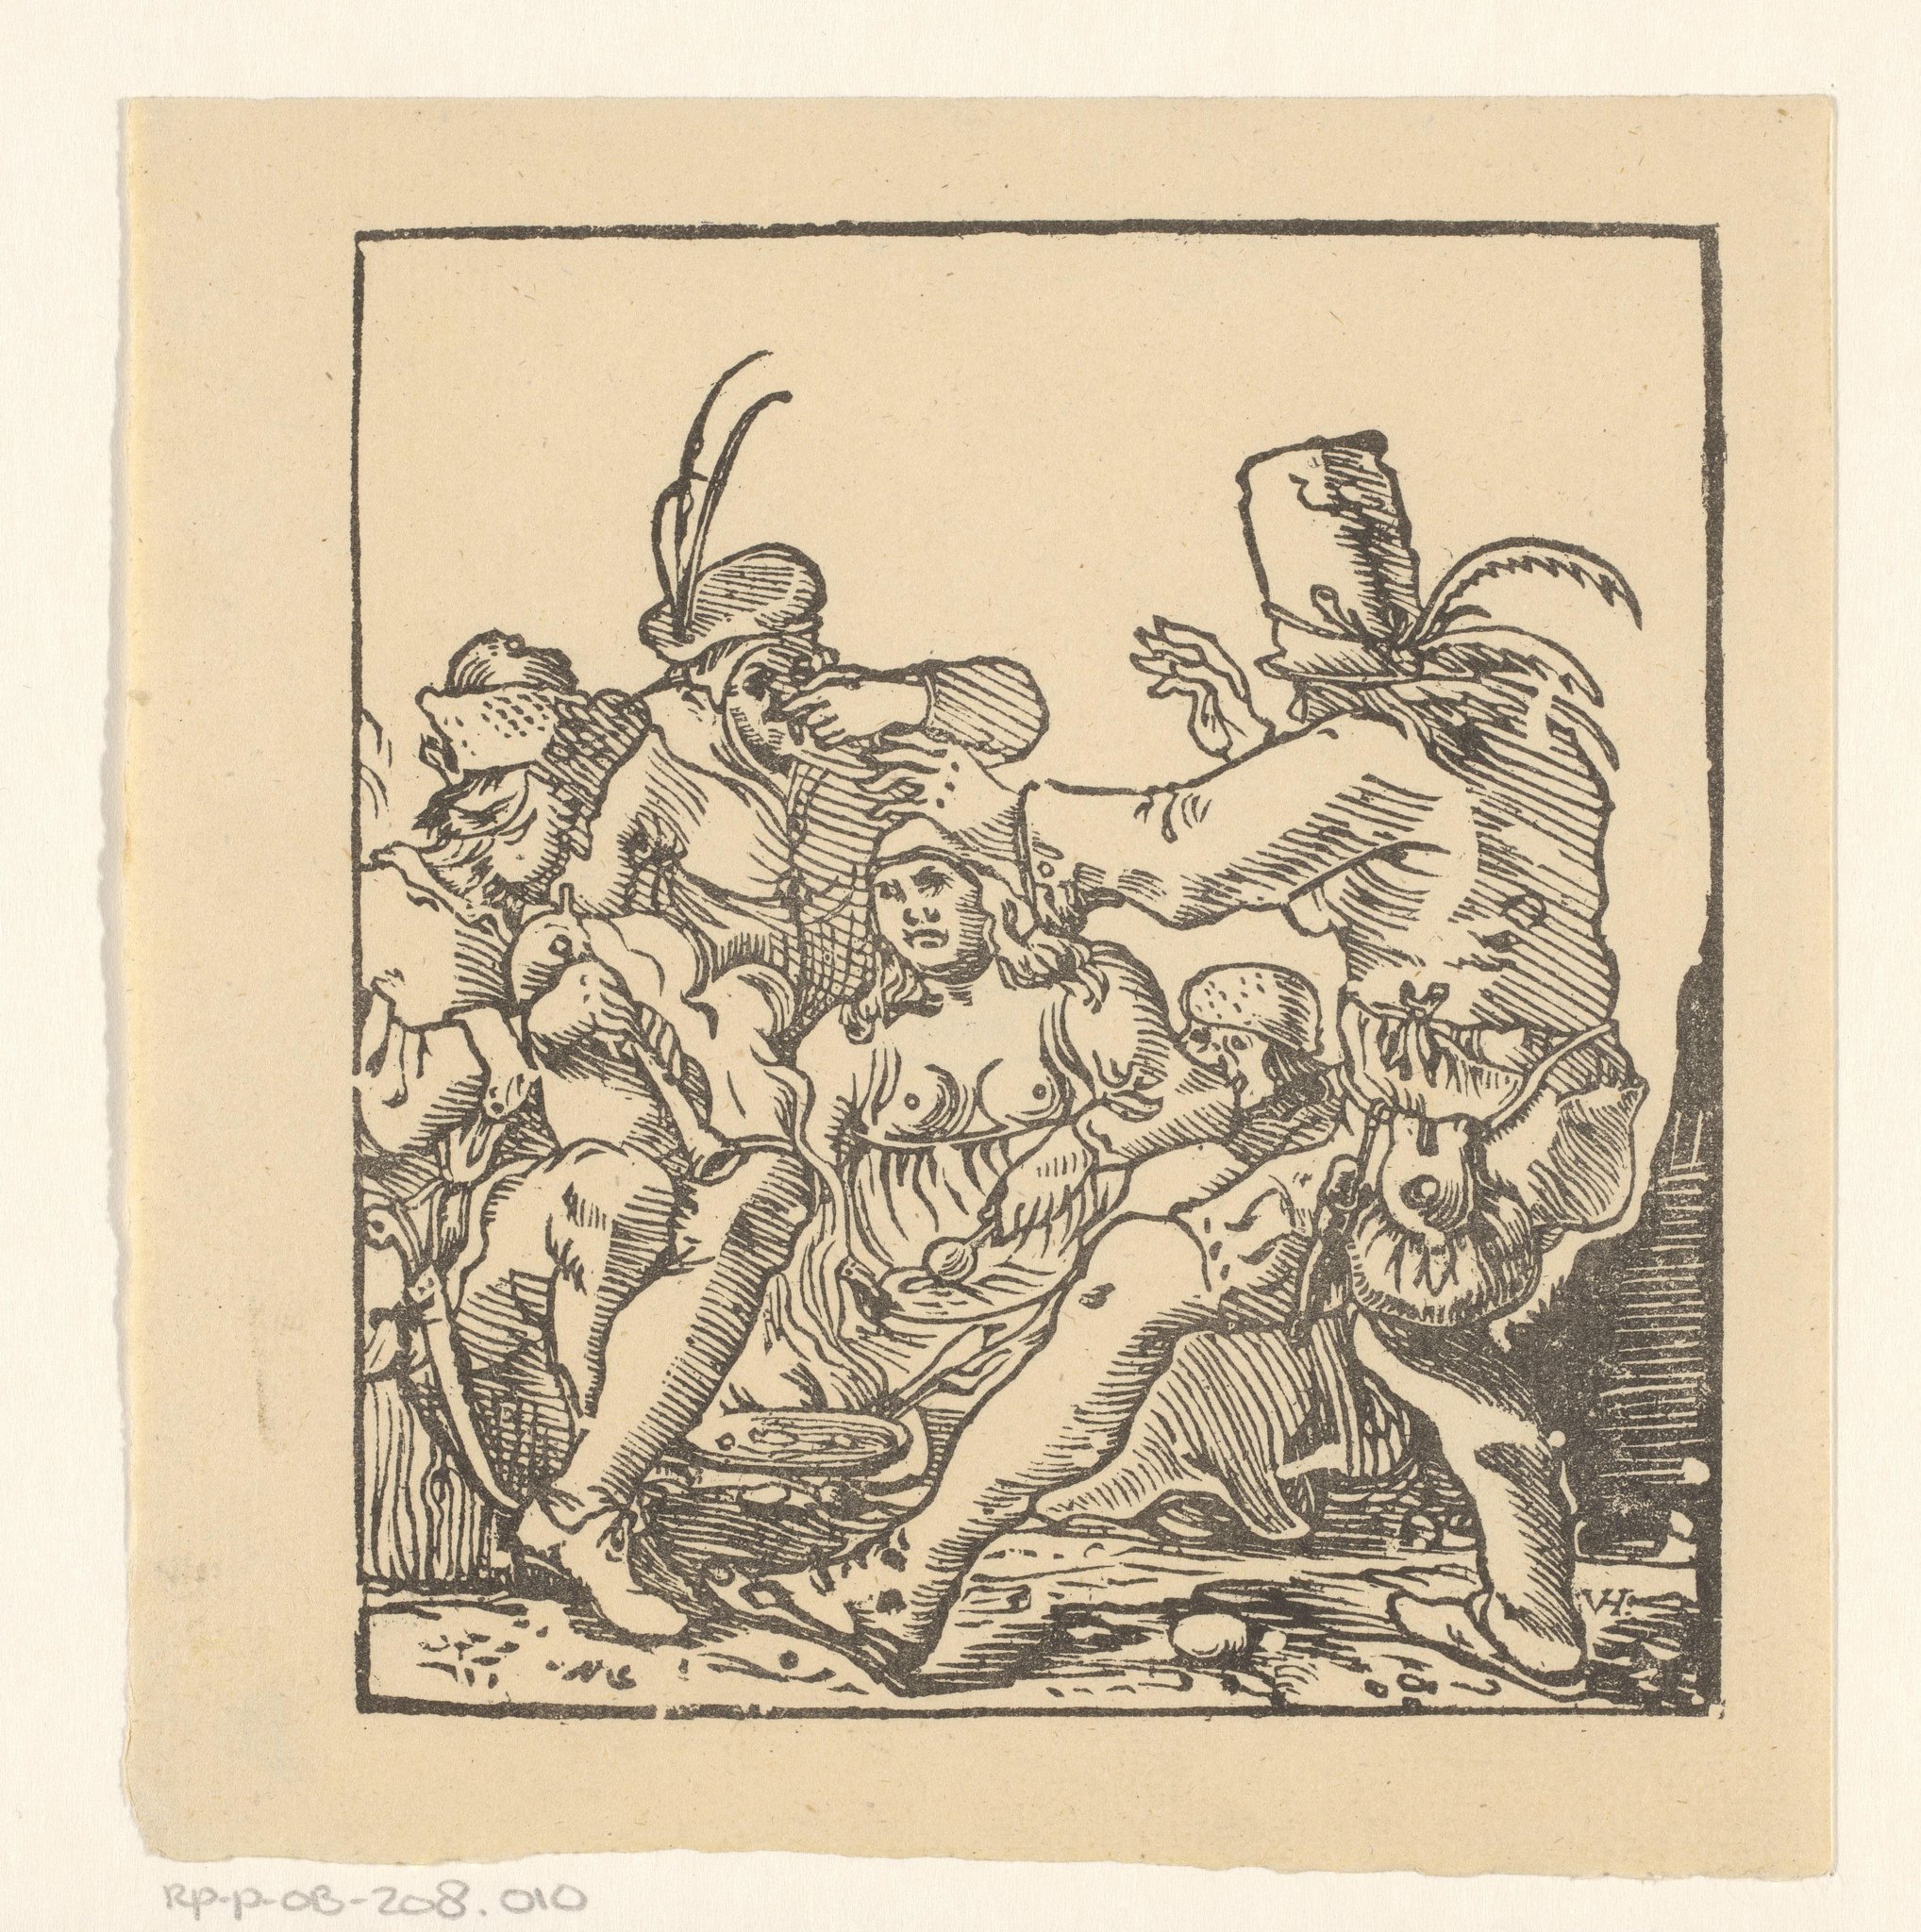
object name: print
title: Het vuile huishouden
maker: monogrammist vh (17e eeuw)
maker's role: print maker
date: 1640-1660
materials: paper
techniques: woodcut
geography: netherlands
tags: badly run house, bagpipe, musette, eating and drinking, holding one's nose closed, dancing games (children's games)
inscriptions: collector's mark: Lugt 2228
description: Rechts danst een man de eierdans op de muziek van een doedelzakspeler. In het midden zit een vrouw eieren te roeren in haar shoot. Links houdt een man zijn neus dicht.